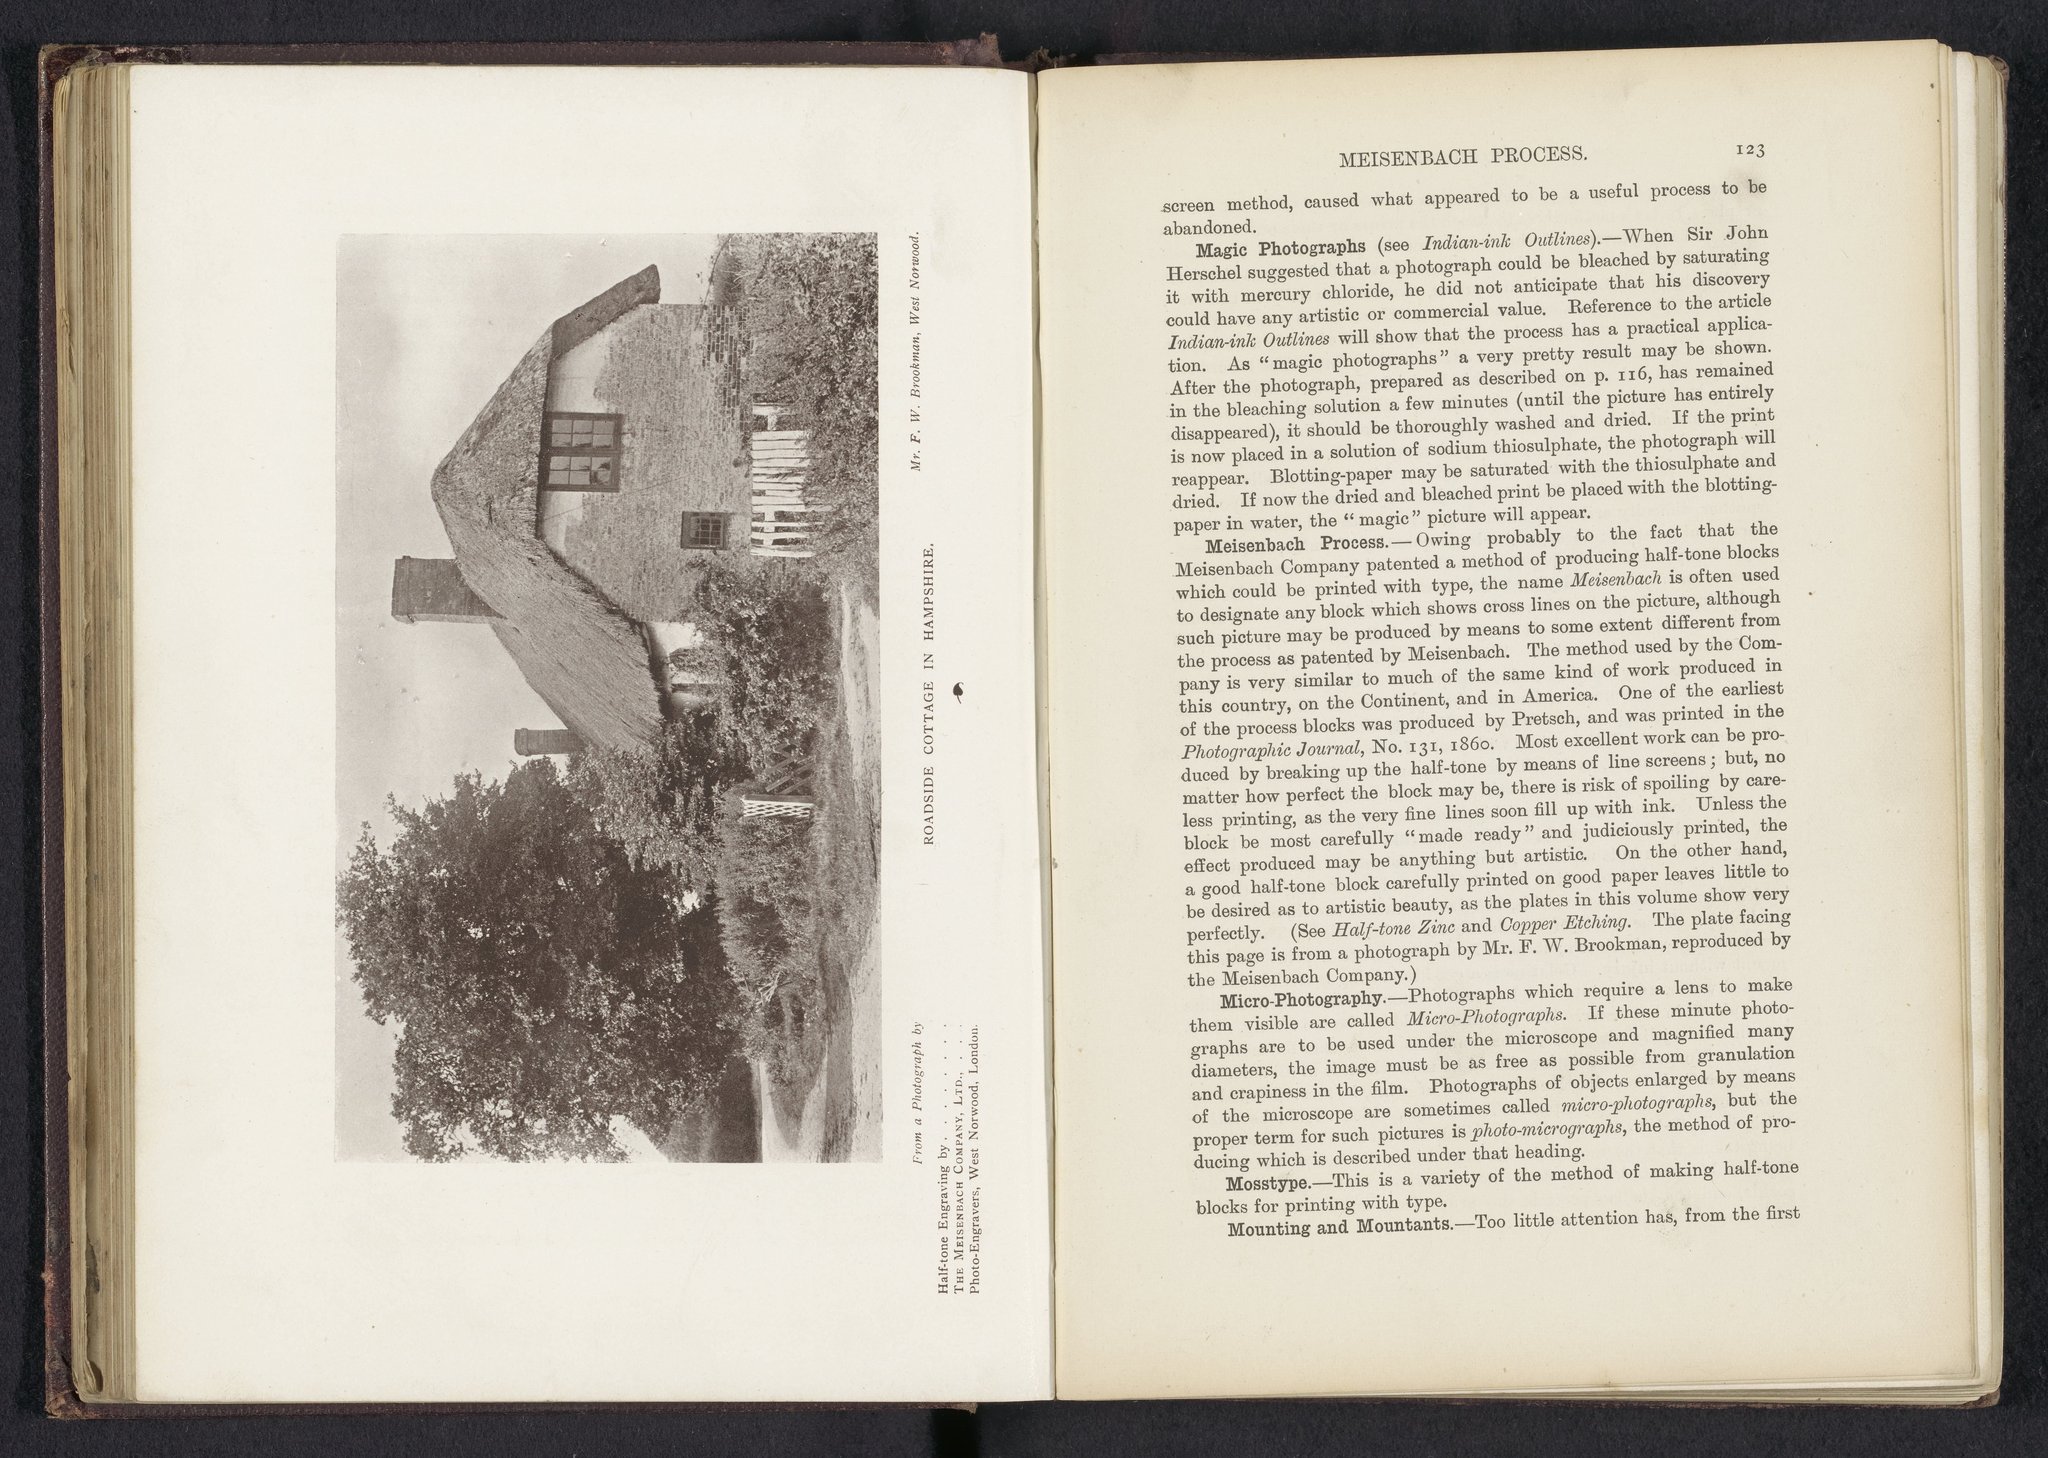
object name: page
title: Roadside cottage in Hampshire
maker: f.w. brookman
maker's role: fotograaf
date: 1889-1899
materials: paper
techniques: autotype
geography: west norwood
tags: cottage, façade (of house or building)